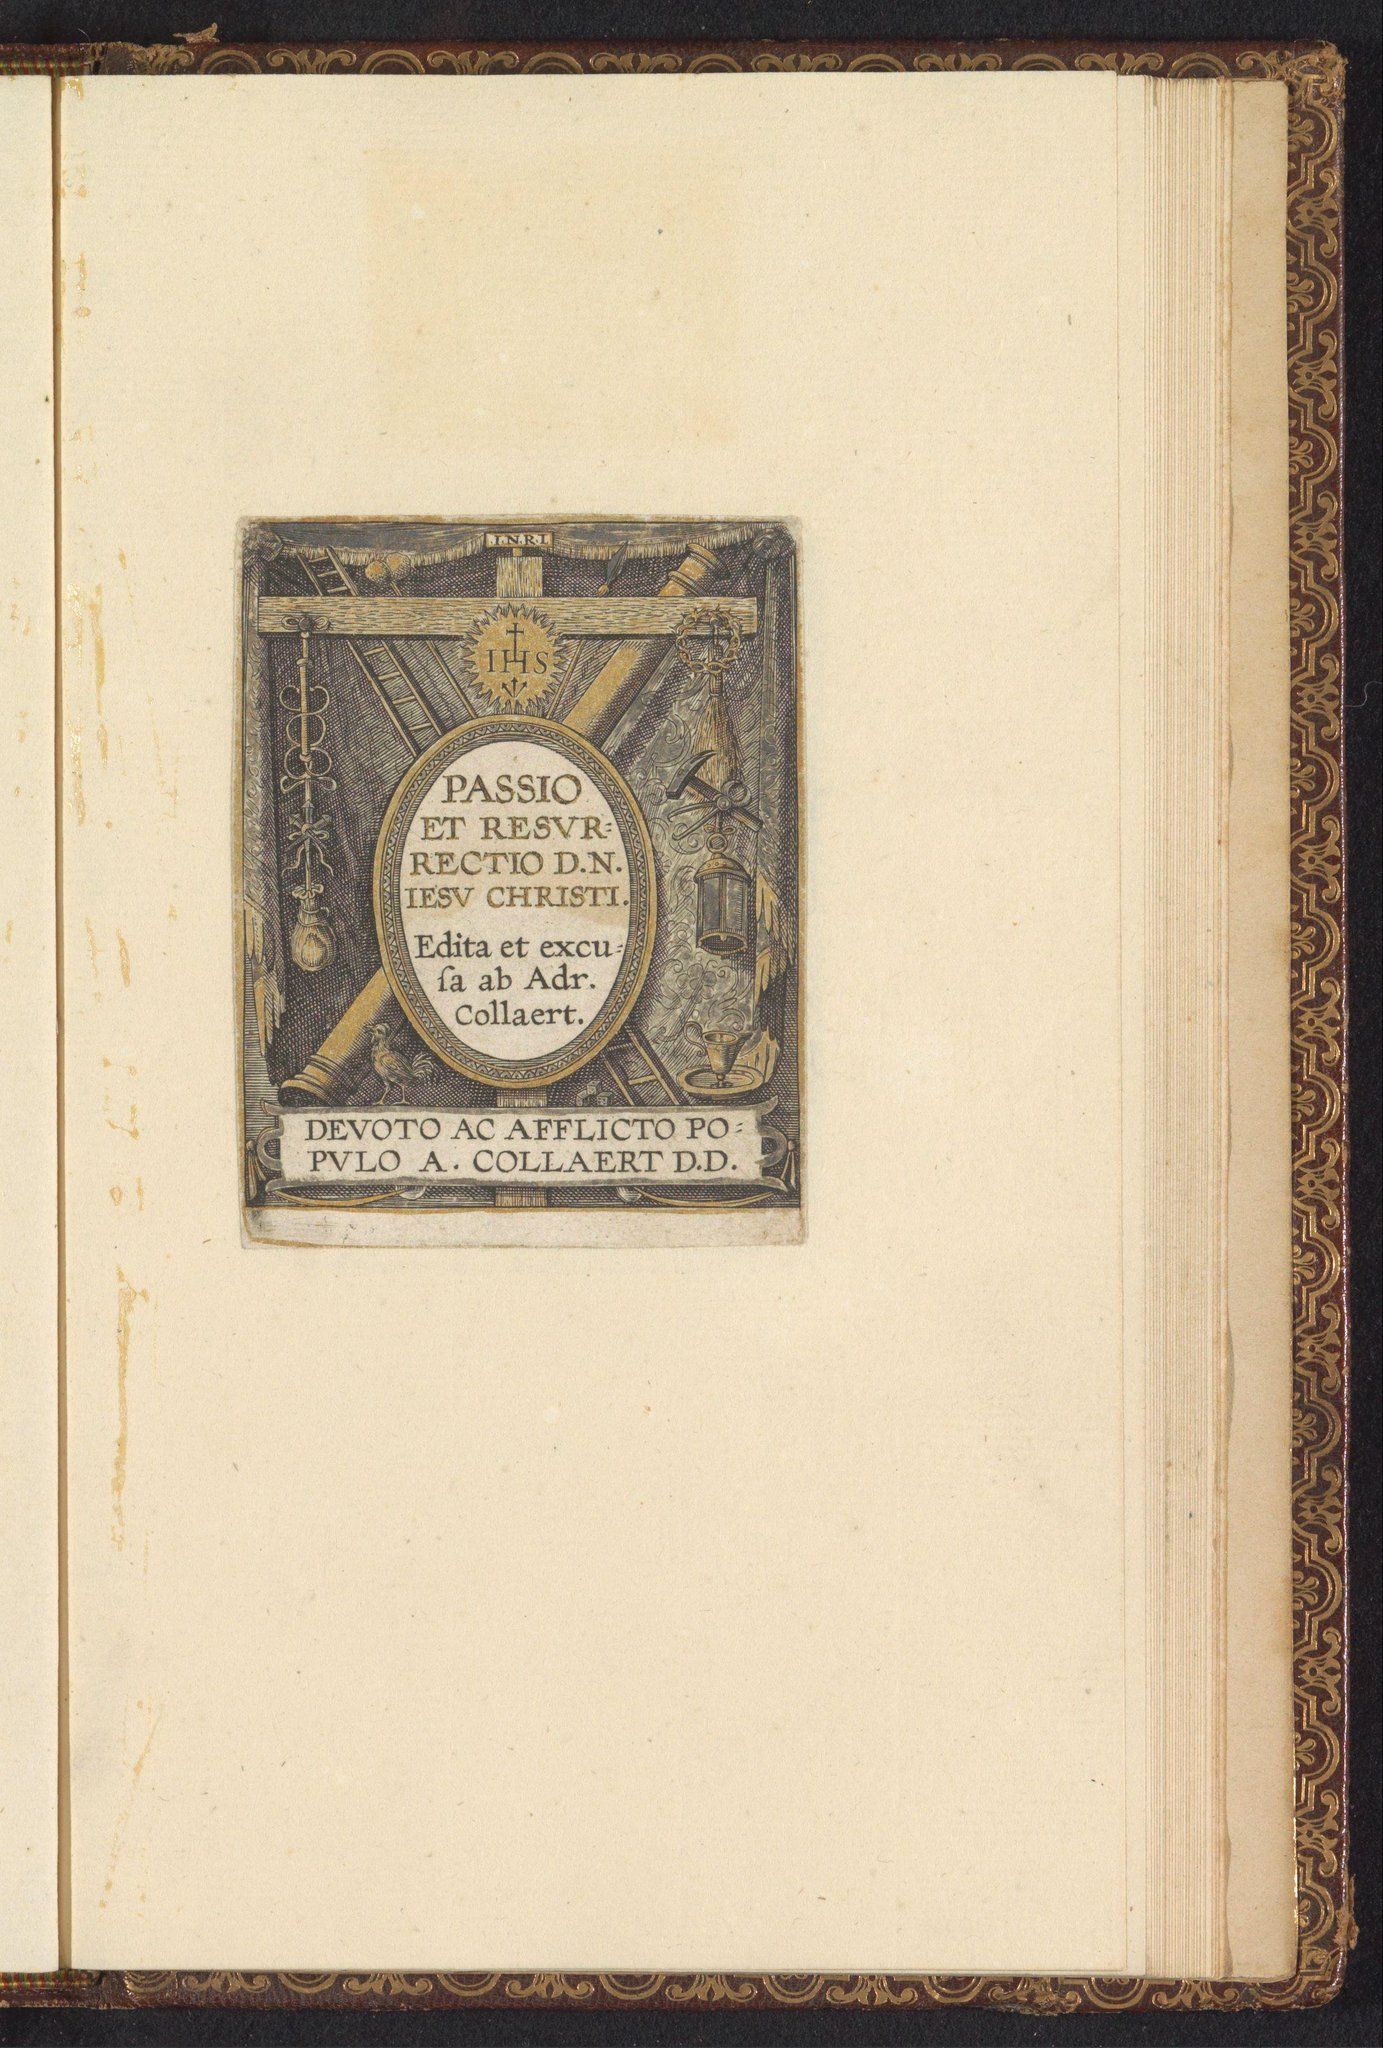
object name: print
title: Titelprent voor de serie: Passio et resurrectio D.N. Iesu Christi. Edita et excusa ab Ad. Collaert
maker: adriaen collaert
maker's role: draughtsman, print maker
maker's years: 1560-1618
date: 1580-1590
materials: gold, paper, silver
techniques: engraving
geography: antwerp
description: Titelprent voor de serie over de passie van Christus: Passio et resurrectio D.N. Iesu Christi. Edita et excusa ab Ad. Collaert. In prentalbum met twee reeksen van respectievelijk 34 en 24 gravures met scènes uit het leven en het lijdensverhaal van Christus.